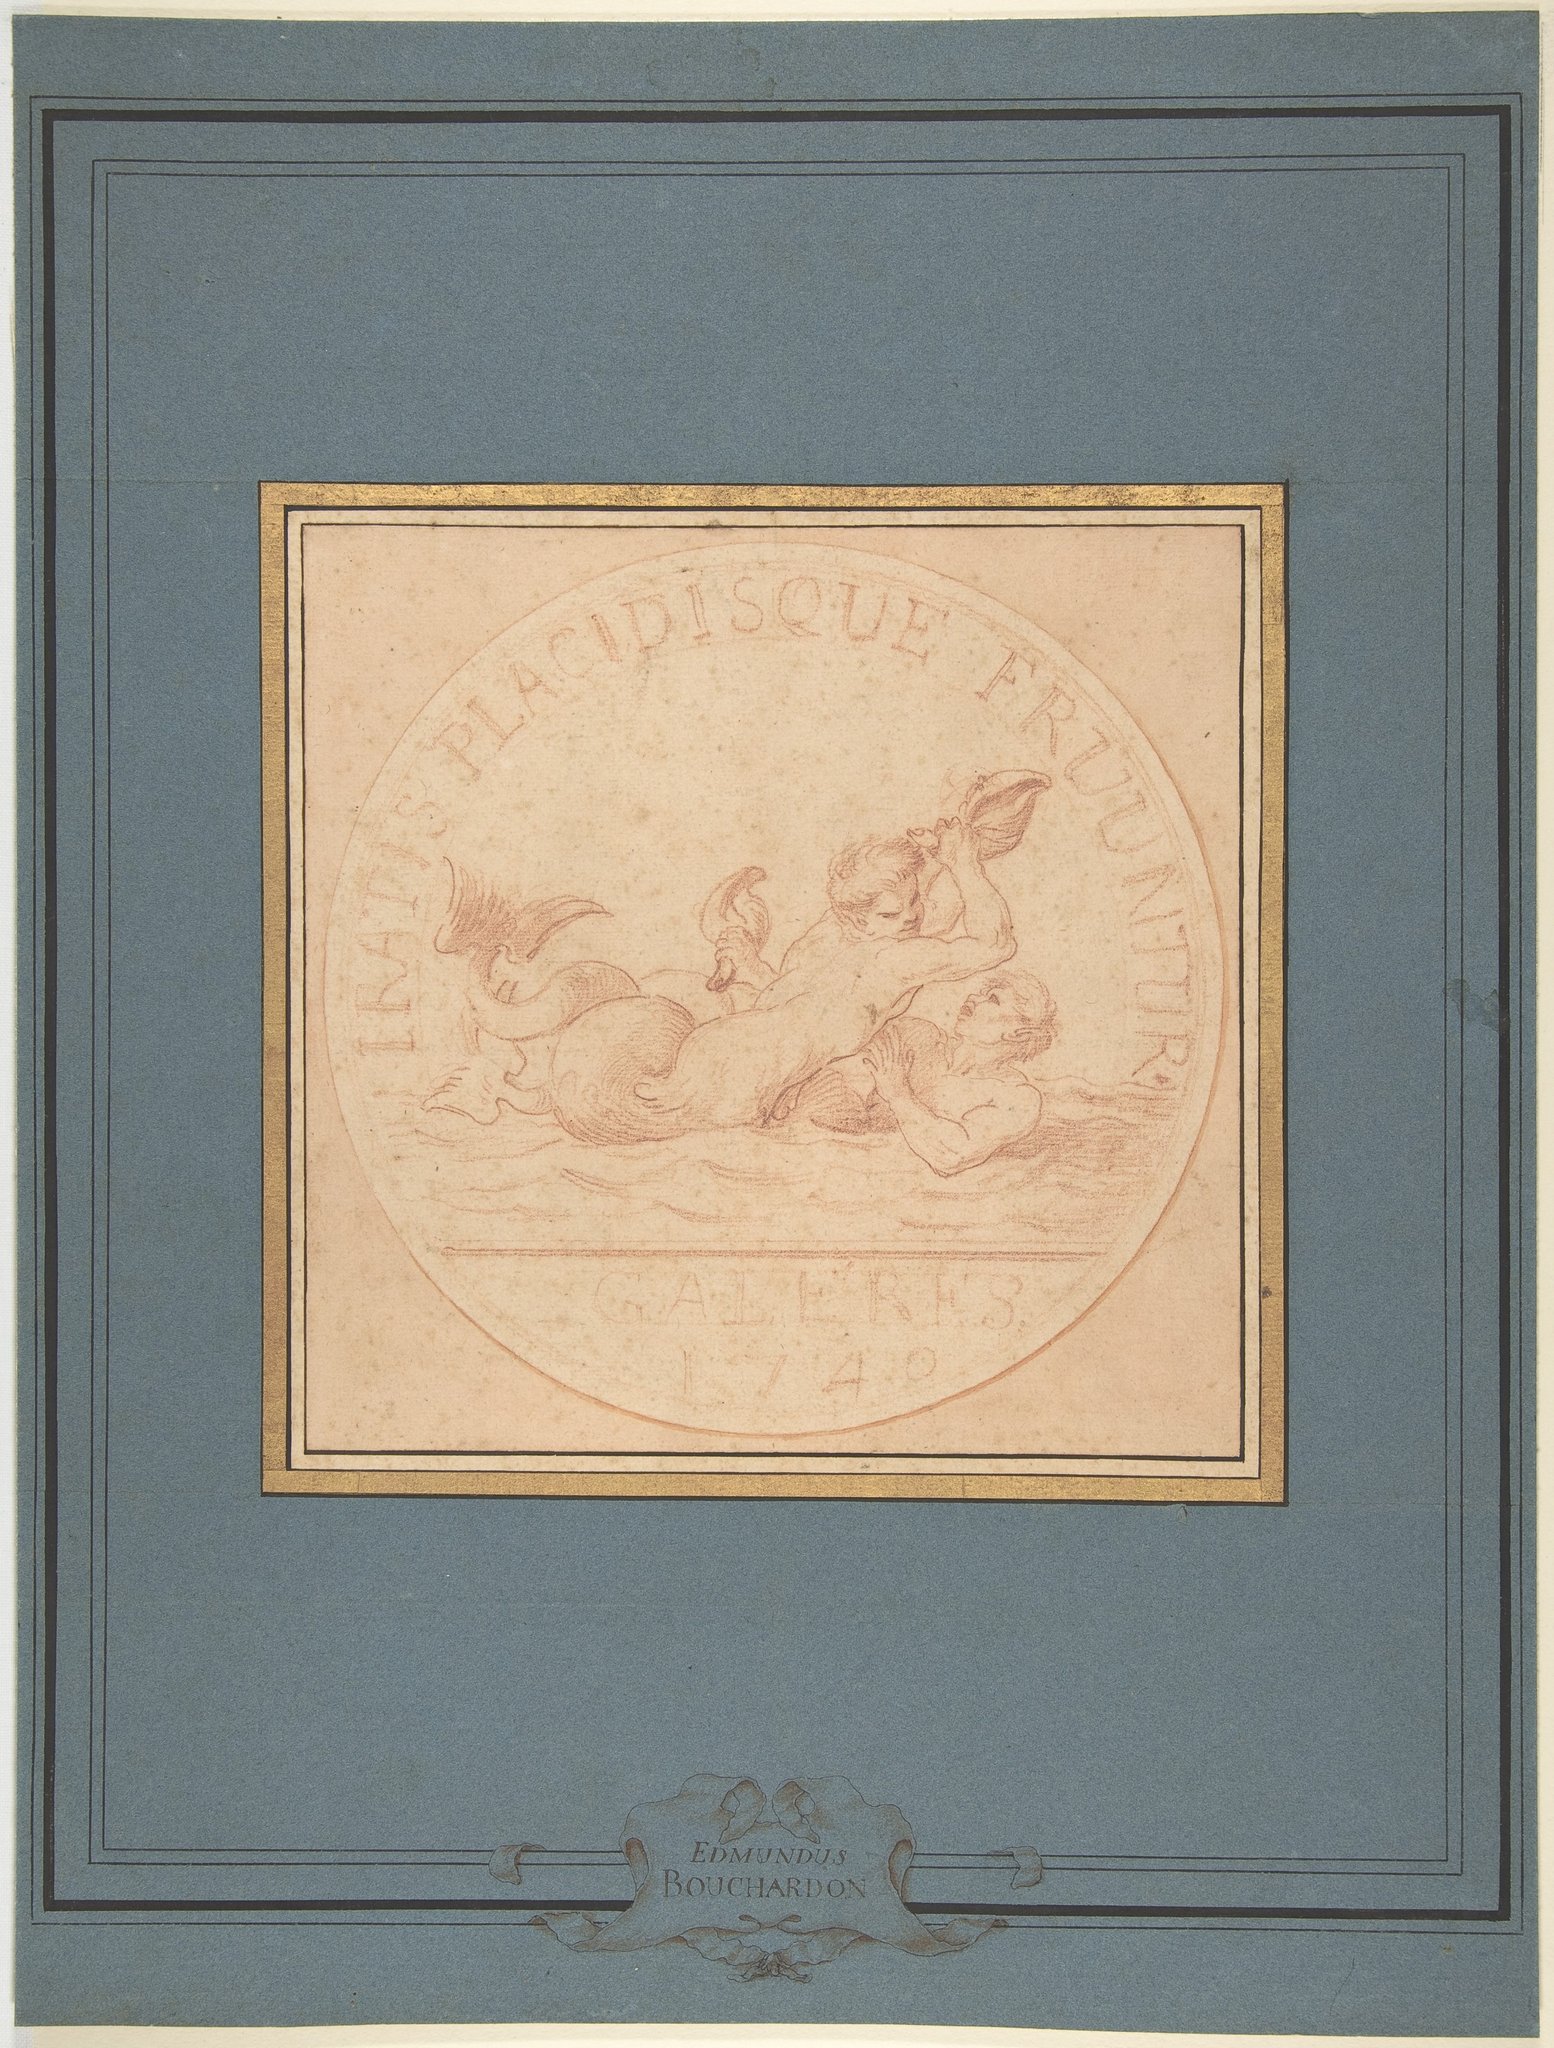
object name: drawing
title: Design for a Token: Galères, 1740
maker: edme bouchardon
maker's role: artist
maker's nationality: french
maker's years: 1698-1762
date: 1740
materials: chalk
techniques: wash